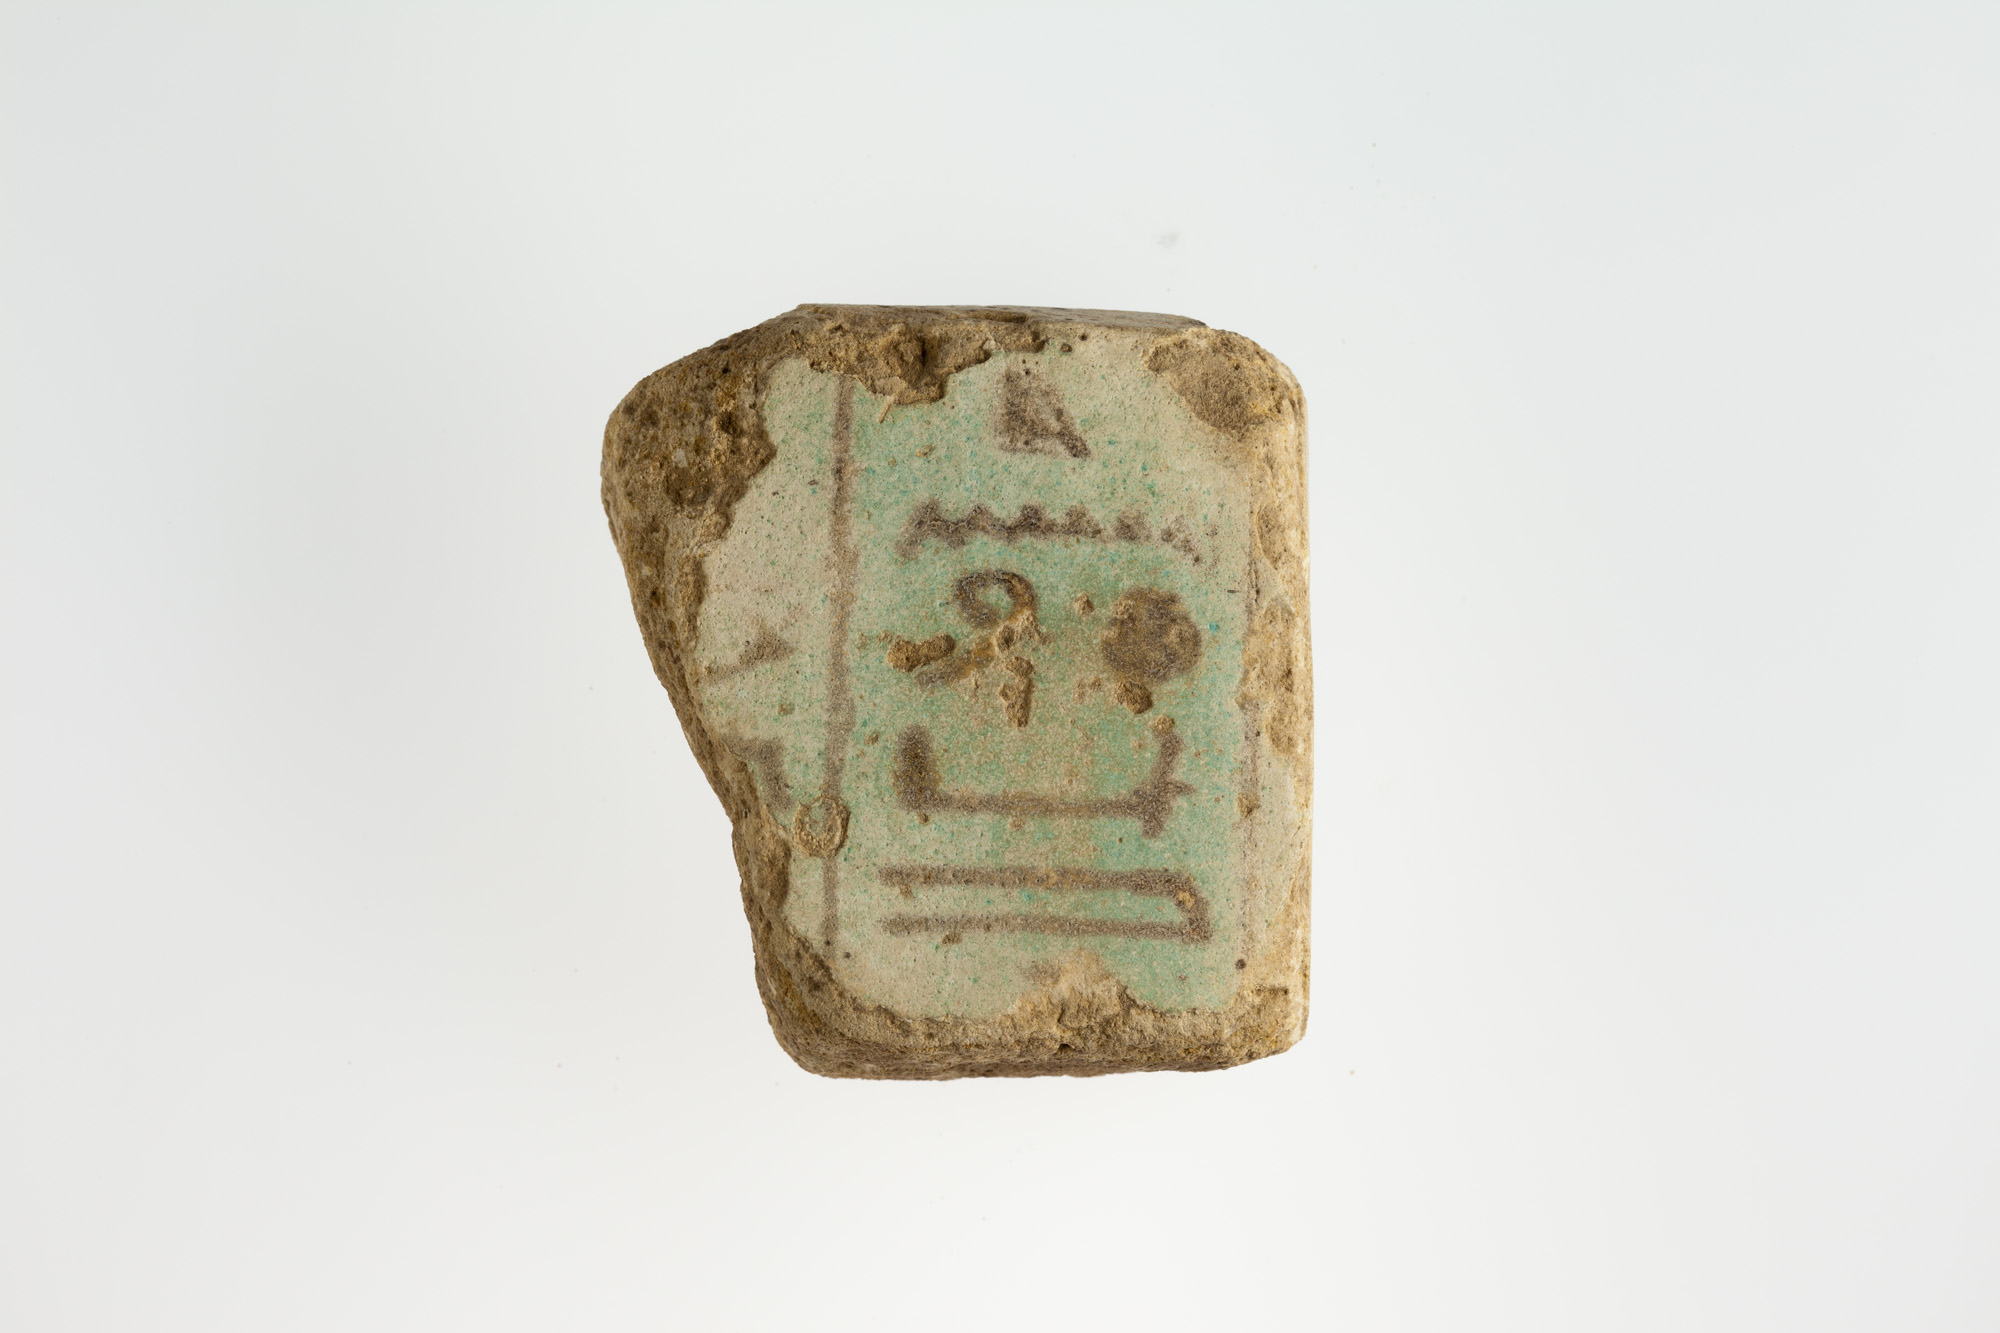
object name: tile fragment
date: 1981-1640 BCE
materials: faience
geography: egypt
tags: hieroglyphs